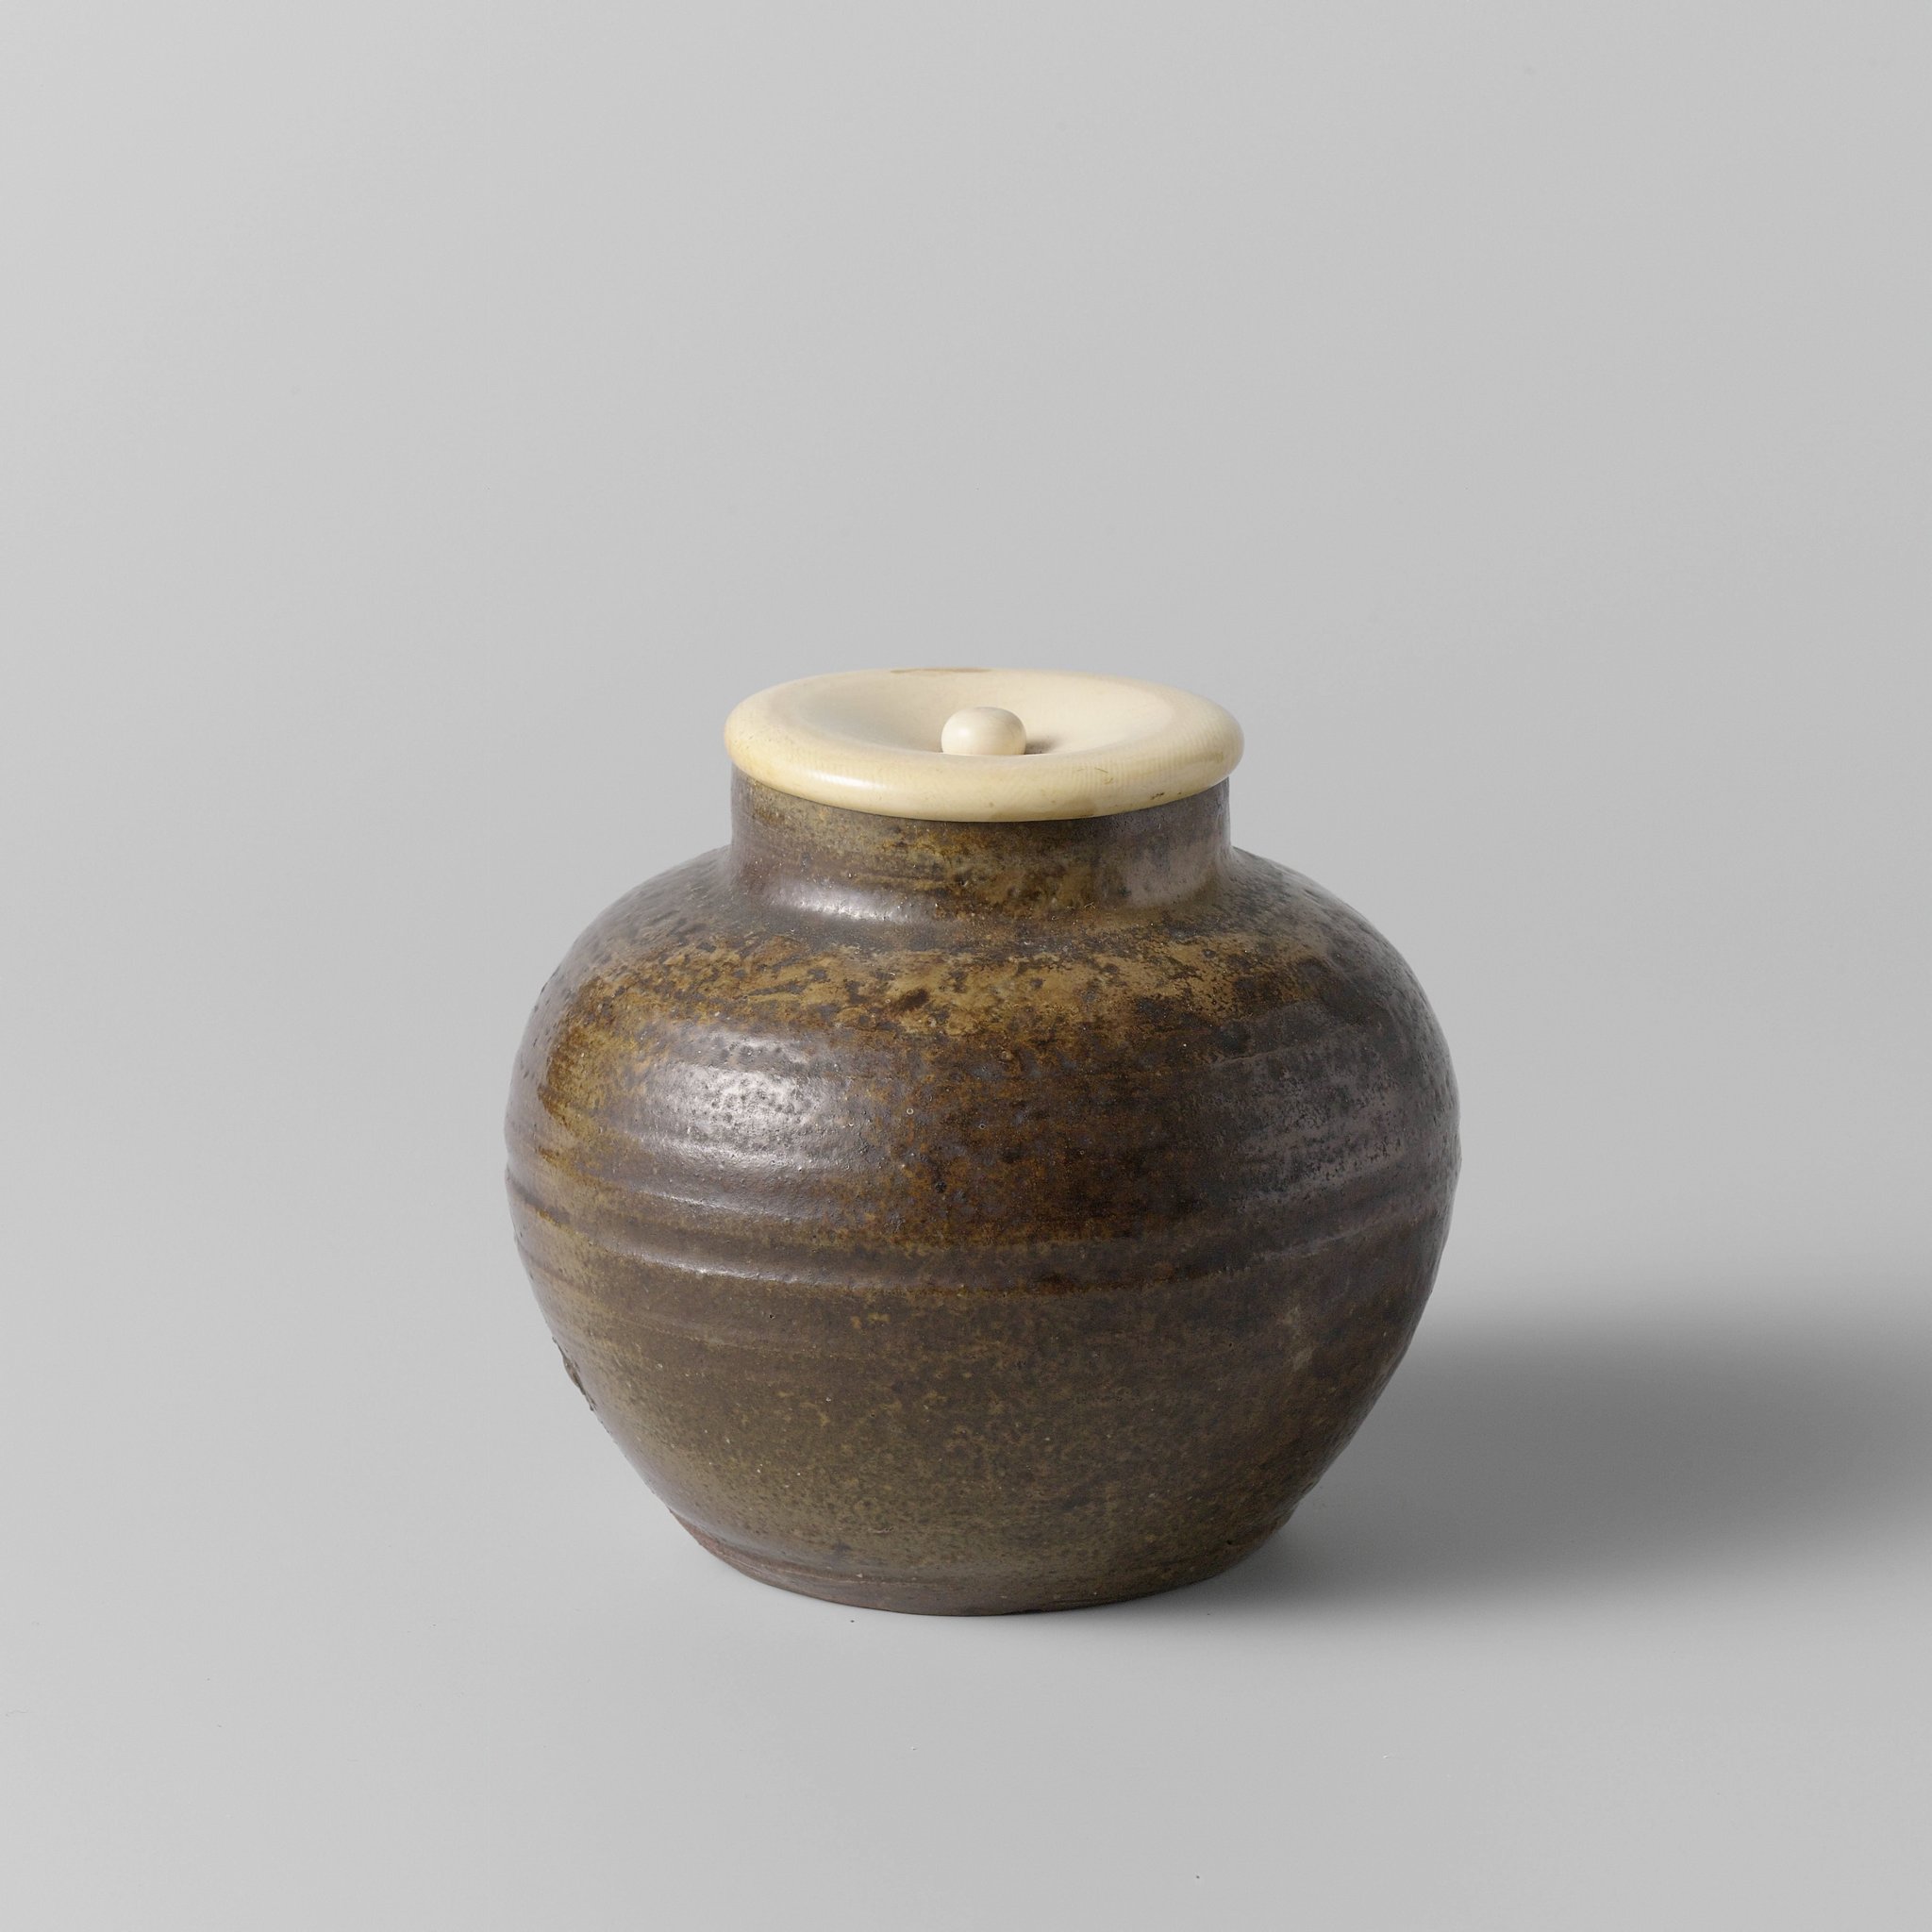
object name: stoftheebus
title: Tea caddy with a brown glaze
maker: Anonymous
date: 1600-1800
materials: glaze, ivory, stoneware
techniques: firing, turning, vitrification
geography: shigaraki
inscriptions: label: ‘W592’, label: ‘Vorm Tanetsubo/ Shigaraki/ 18e’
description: Stoftheebus van steengoed in tanetsubo-vorm met een ivoren deksel, gedeeltelijk bedekt met een bruin glazuur. Het onderste deel van de bus is ongeglazuurd. Oud label aan de binnenzijde met 'Vorm Tanetsubo/ Shigaraki/ 18e'; oud label op de onderzijde met 'W592'. Shigaraki.